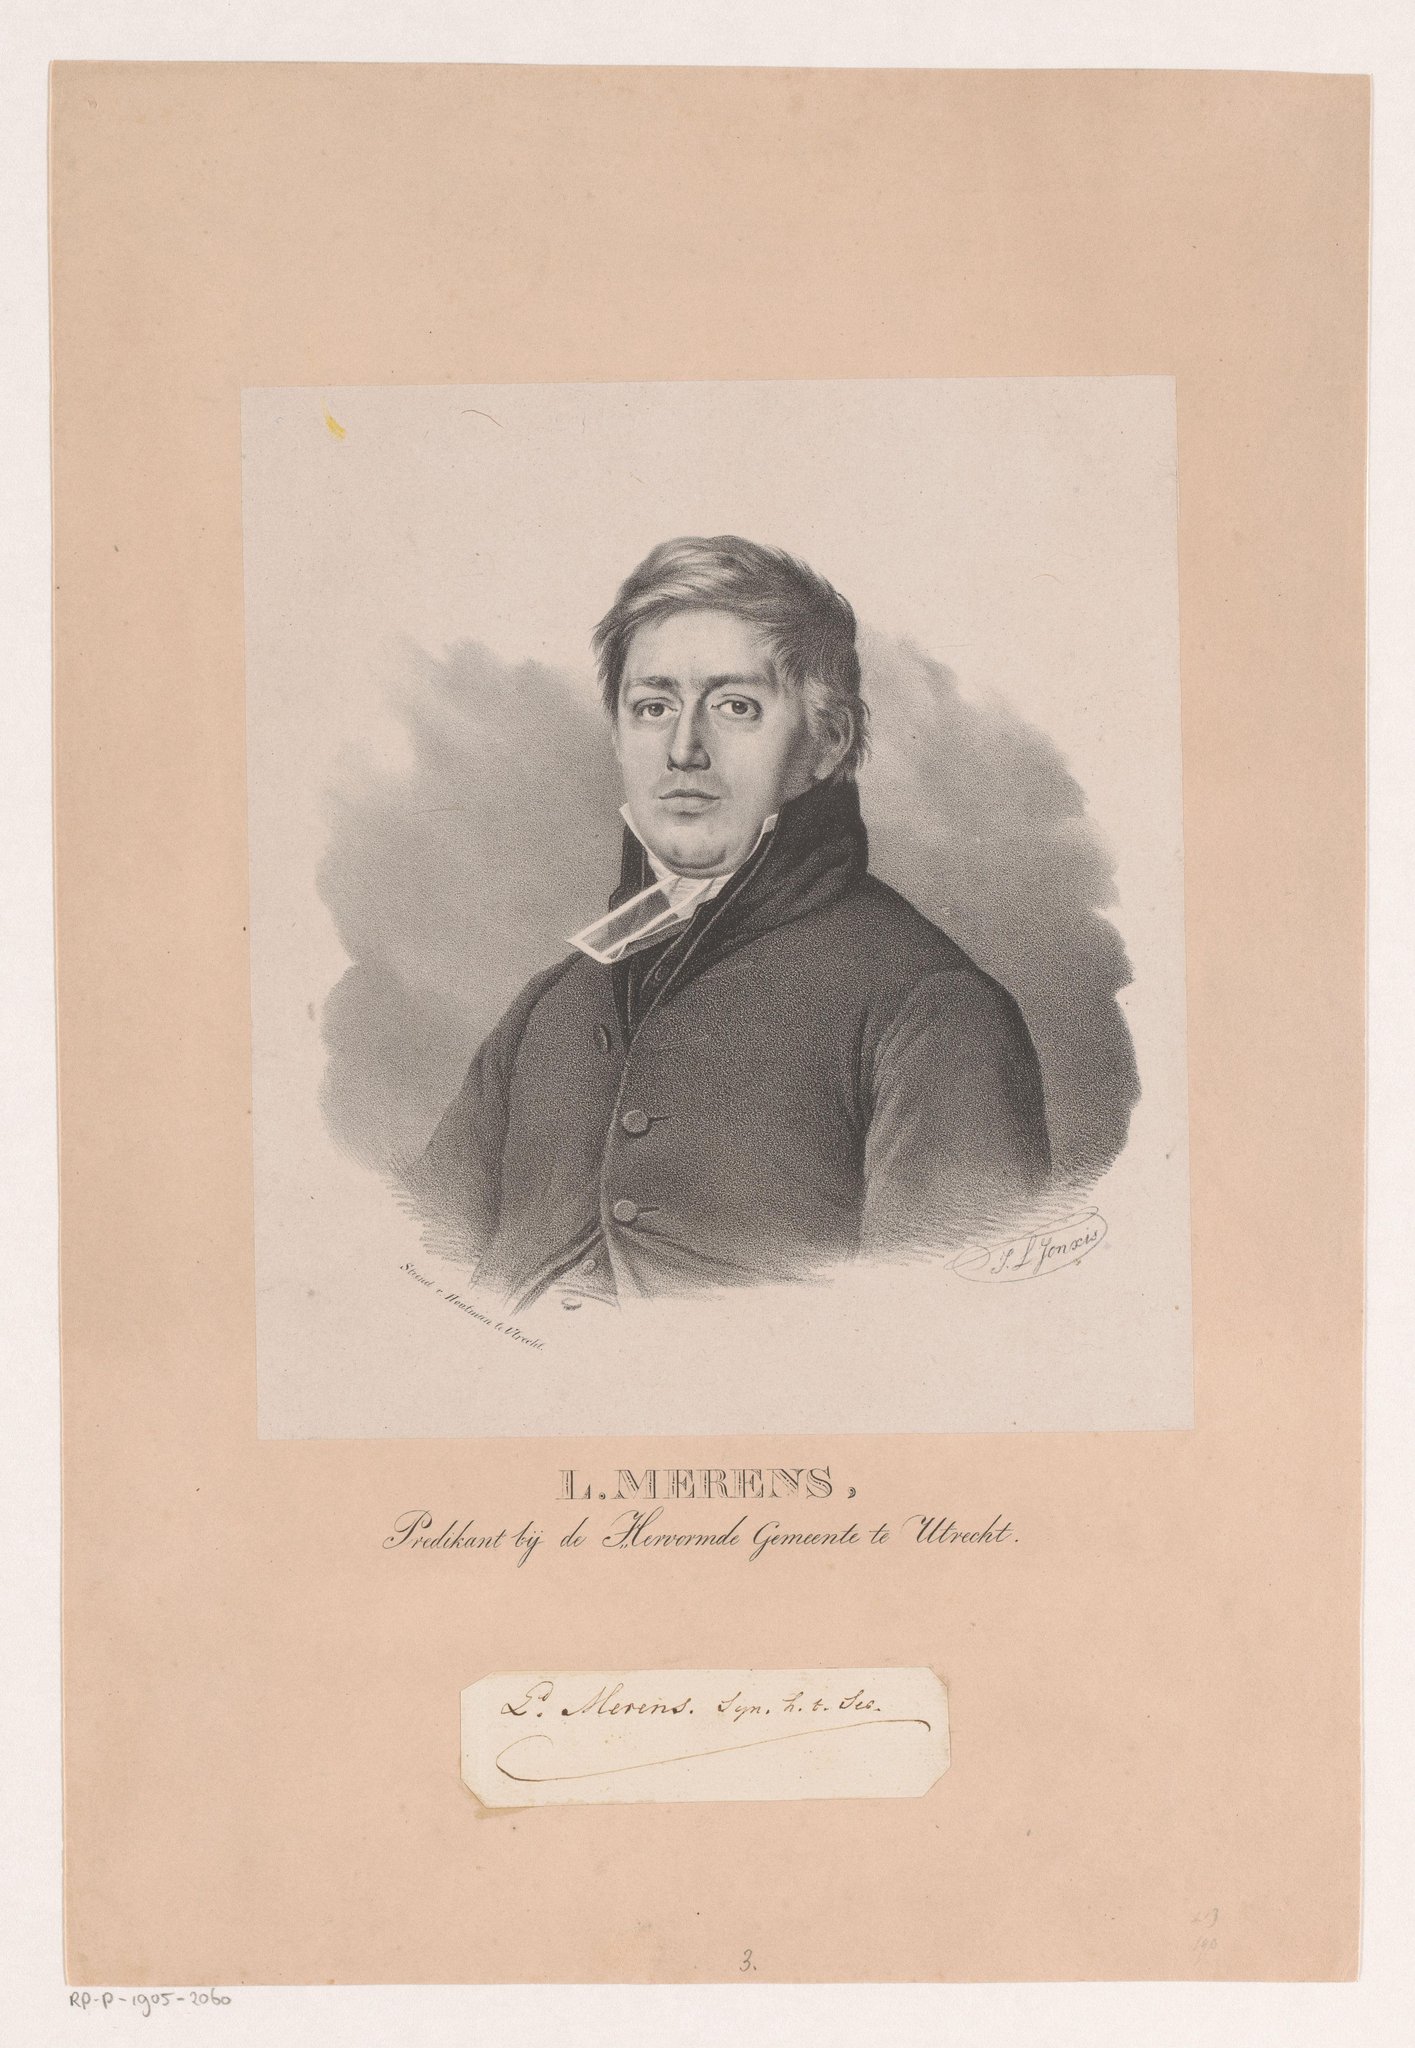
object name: print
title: Portret van Lucas Merens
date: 1828-1843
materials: paper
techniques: lithograph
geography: utrecht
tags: historical persons (+ (full) bust portrait)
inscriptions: collector's mark: Lugt 2228, inscription: ‘L. Merens Syn h. t. Ses’